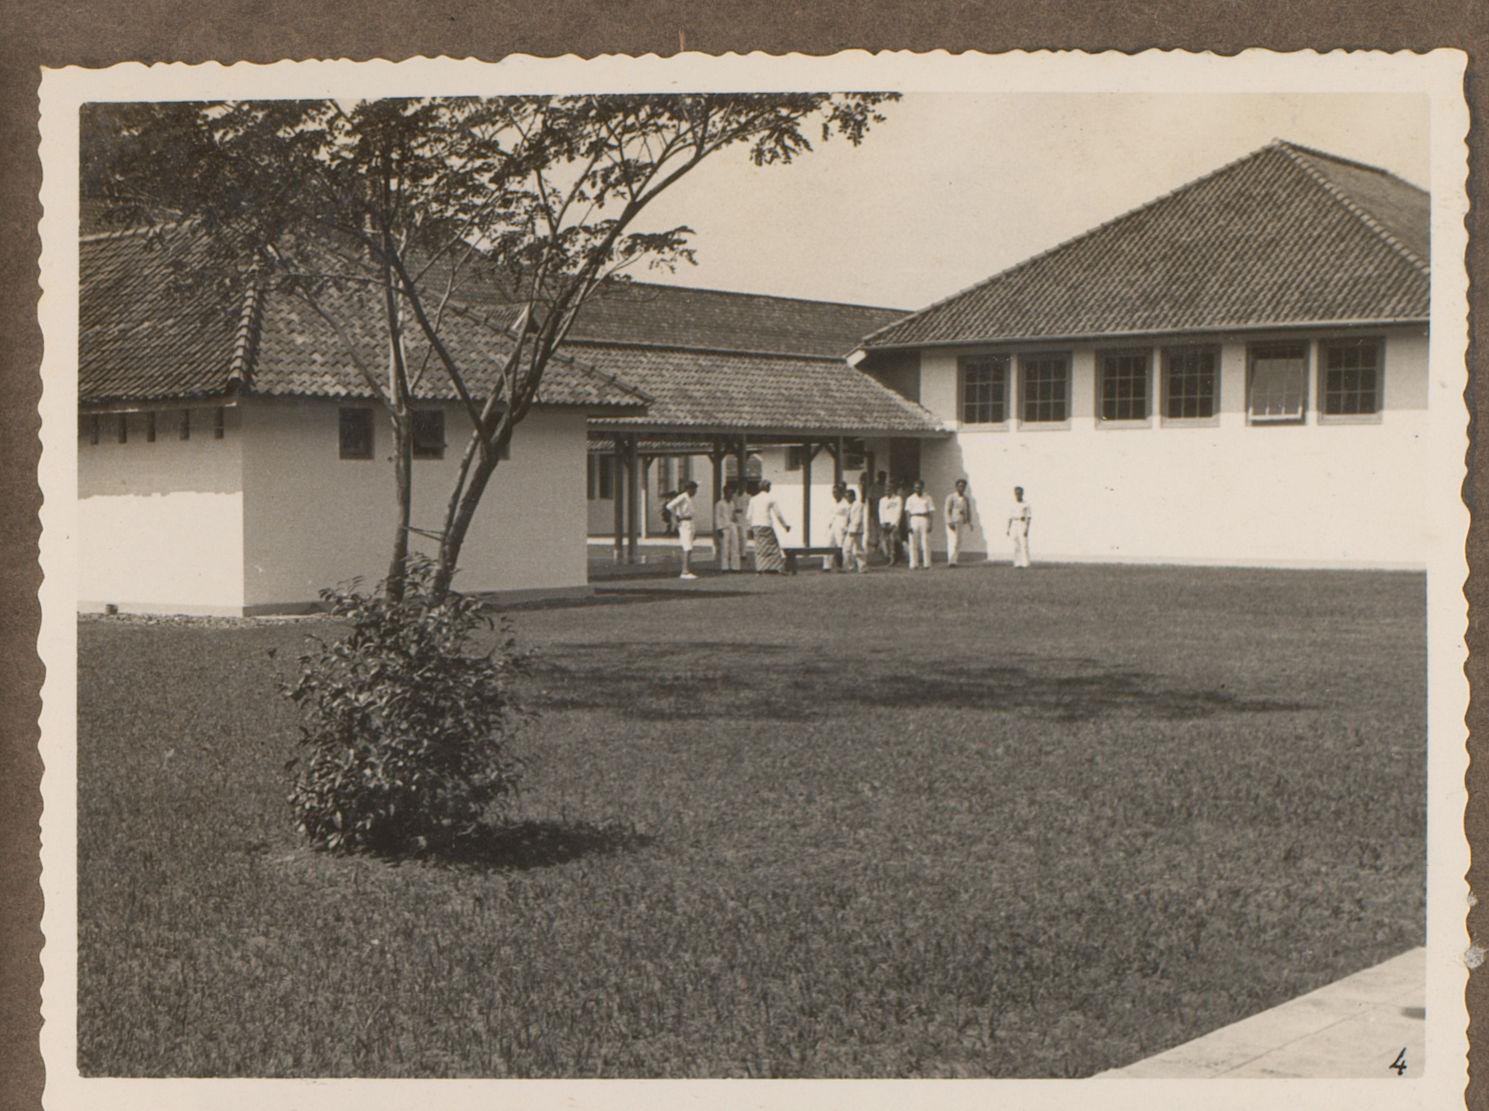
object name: photograph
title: Modellenzaal van de Prinses Juliana School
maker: Anonymous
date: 1933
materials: photographic support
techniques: gelatin silver print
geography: jogjakarta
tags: vocational education, e.g.: junior technical school (+ building ~ education, tuition), colonial government, dutch east indies, the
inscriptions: inscription: ‘4’, inscription: ‘Modellenzaal / PJS’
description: Gezicht op de modellenzaal van de Prinses Juliana School te Jogyakarta, voor de ingang een groep staande mannen. Foto ingeplakt in het fotoalbum aangeboden aan J.H.A. van der Hoeven bij het beëindigen op 31 juli 1933 van zijn diensttijd bij het Nijverheidsonderwijs in Nederlandsch-Indië.